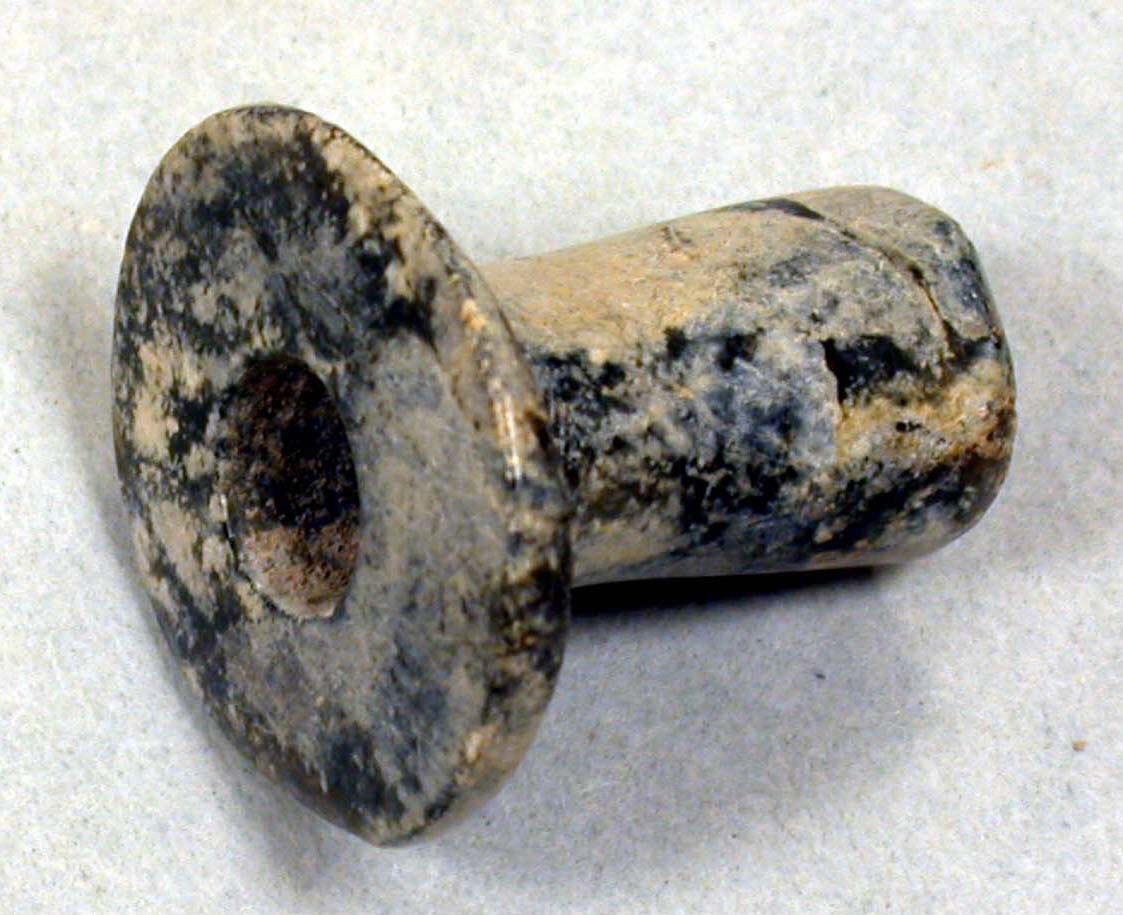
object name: earflare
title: Stone Earflare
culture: mexican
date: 1501-1600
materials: stone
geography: mexico